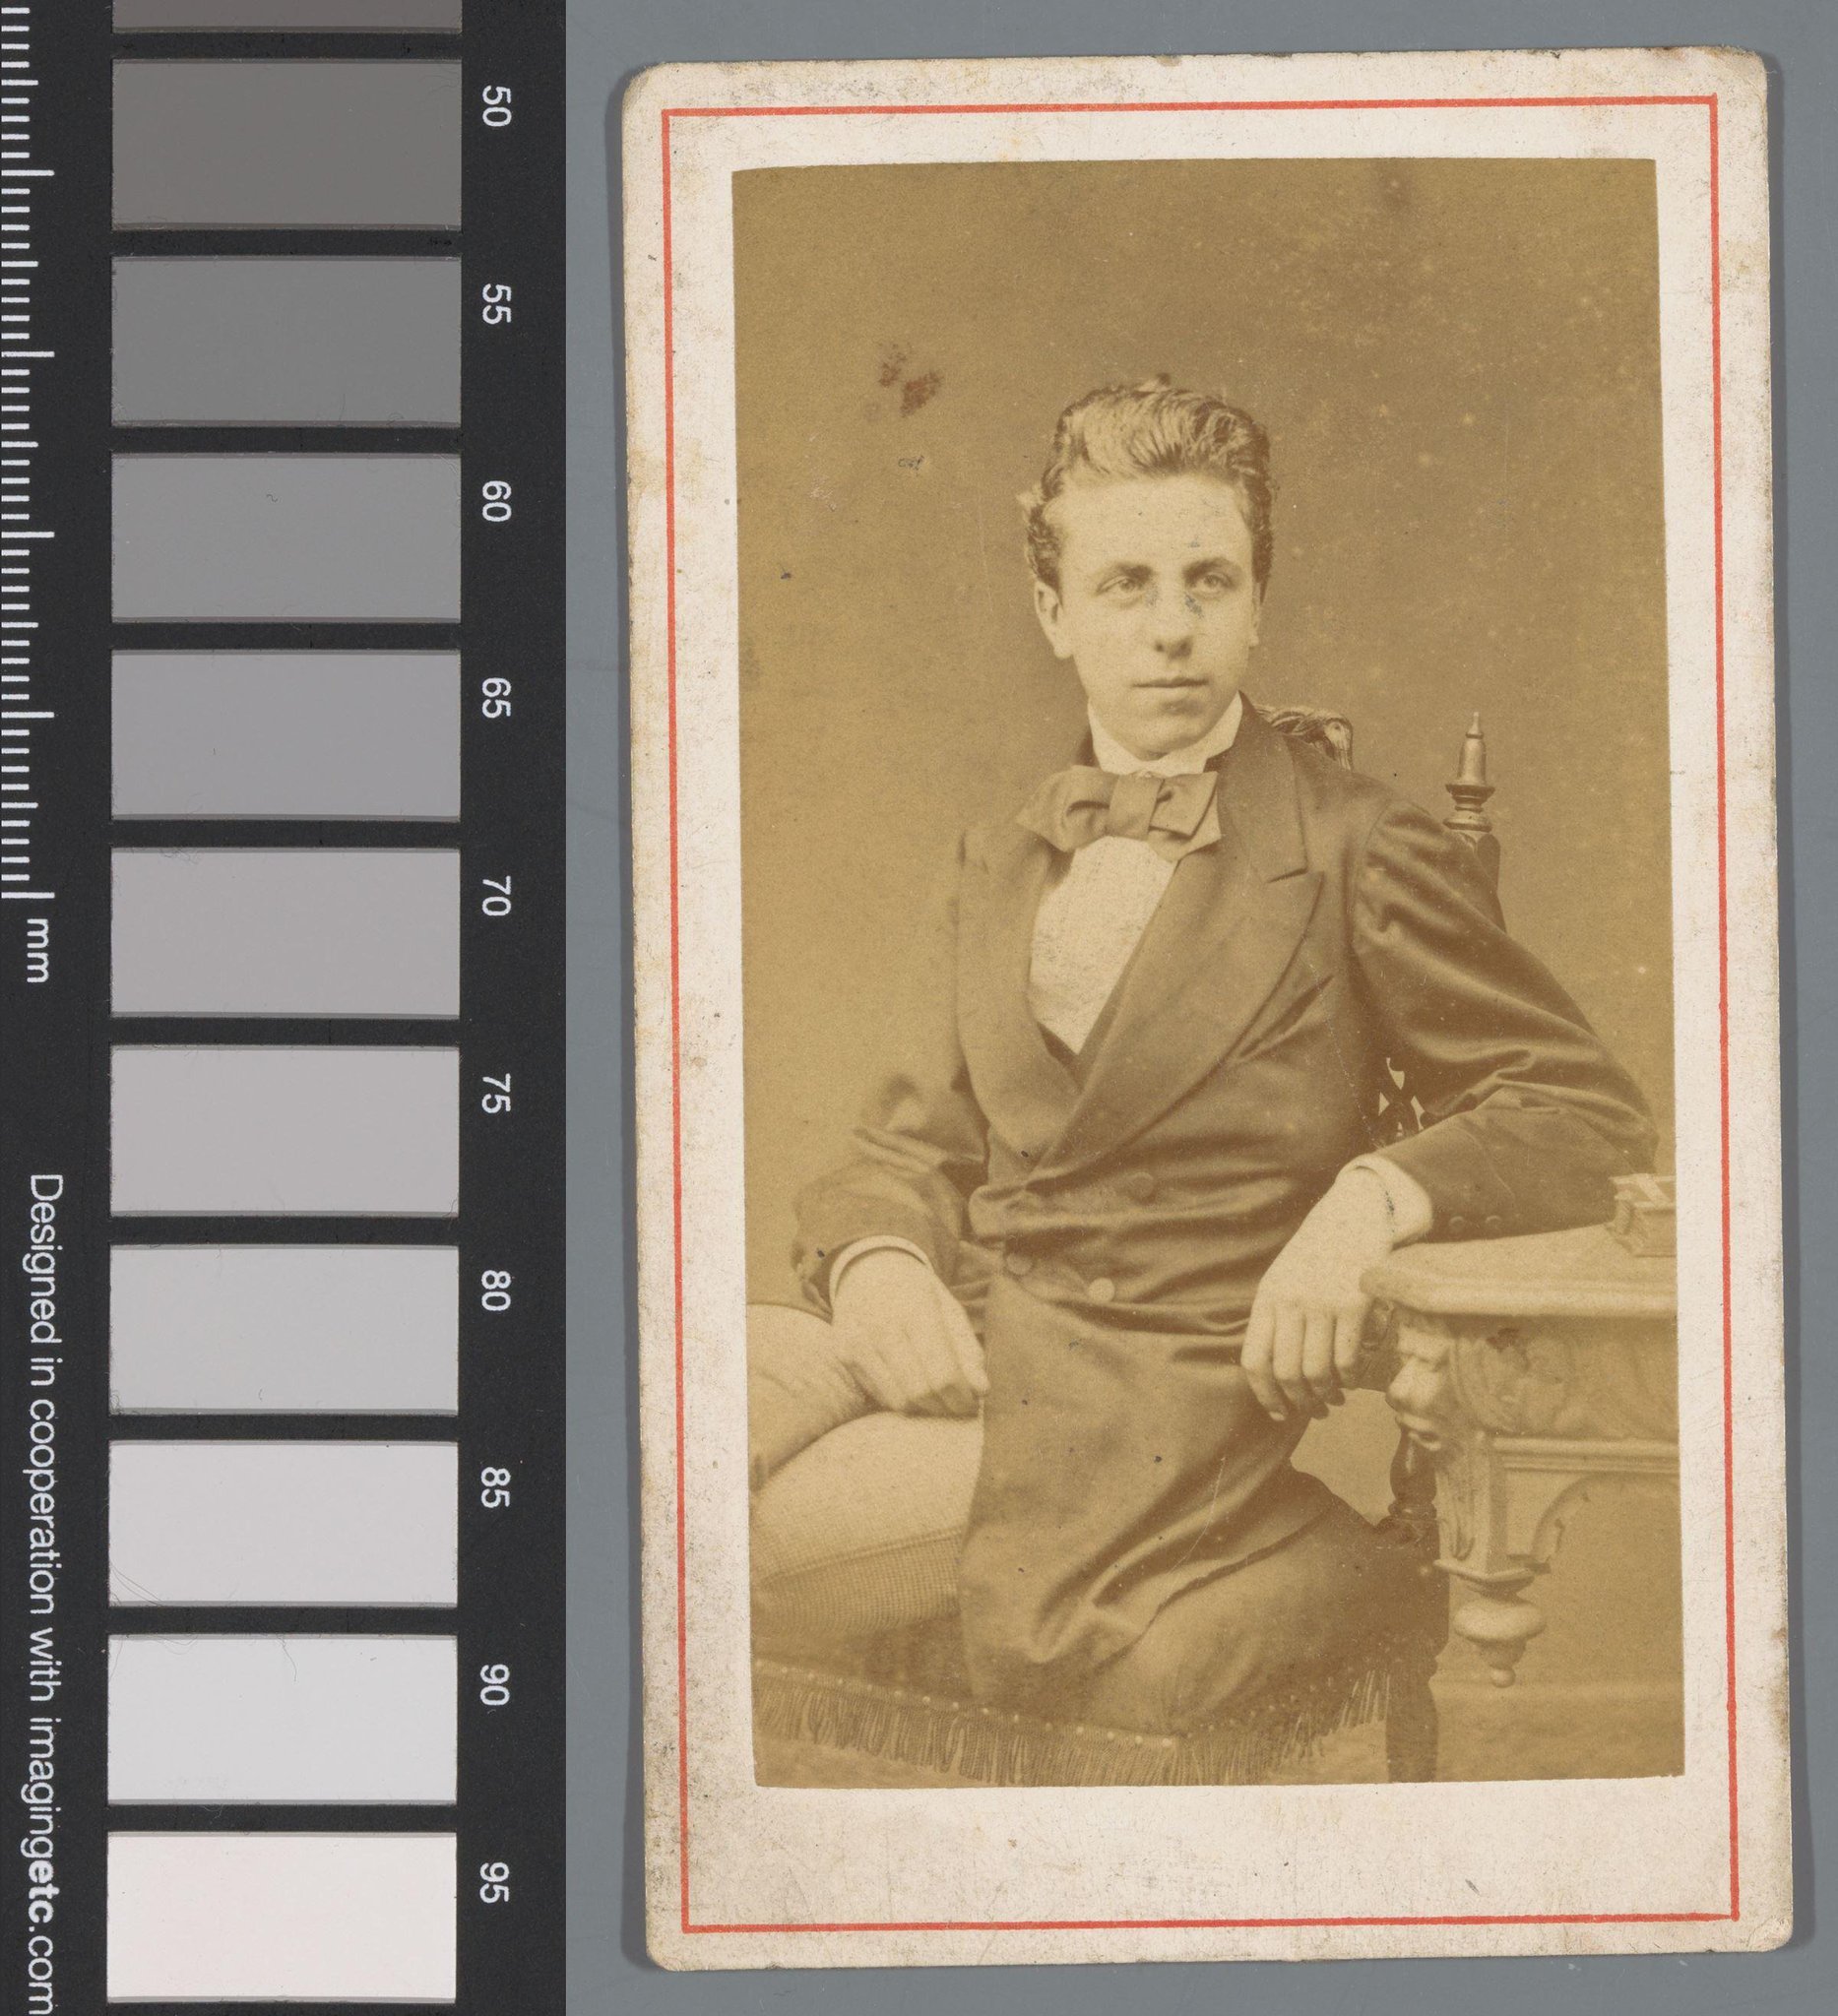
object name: photograph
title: Portret van een onbekende jongeman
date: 1874-1876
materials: cardboard, paper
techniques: albumen print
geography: leuven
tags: youth, adolescent, anonymous historical person portrayed, louvain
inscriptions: inscription: ‘F. Peeters & L. Renard,/ Photographes,/ 103, Rue des Corbeaux, 103,/ Louvain.’